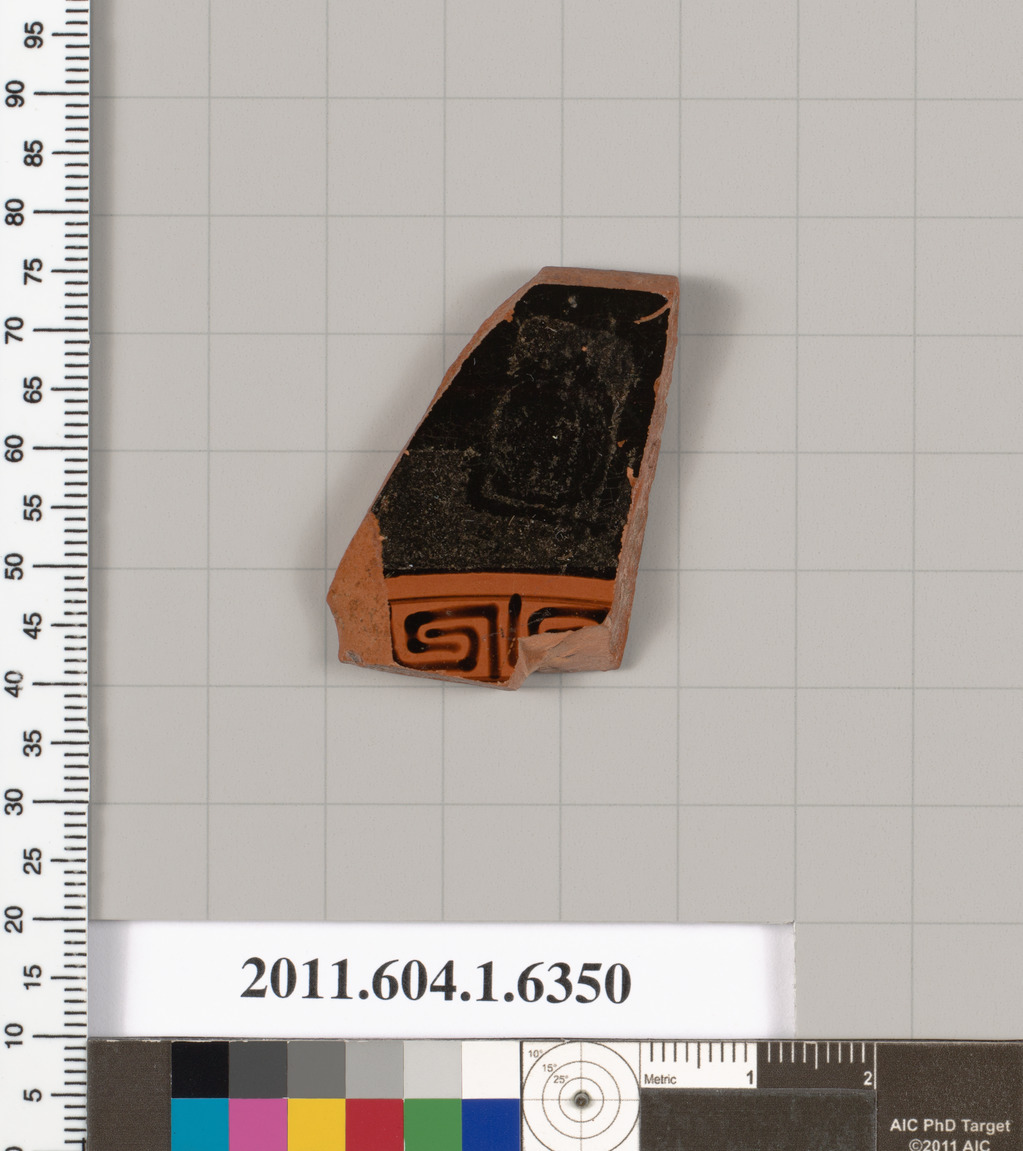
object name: kylix fragment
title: Terracotta fragment of a kylix (drinking cup)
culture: greek, attic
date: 500-480 BCE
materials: terracotta